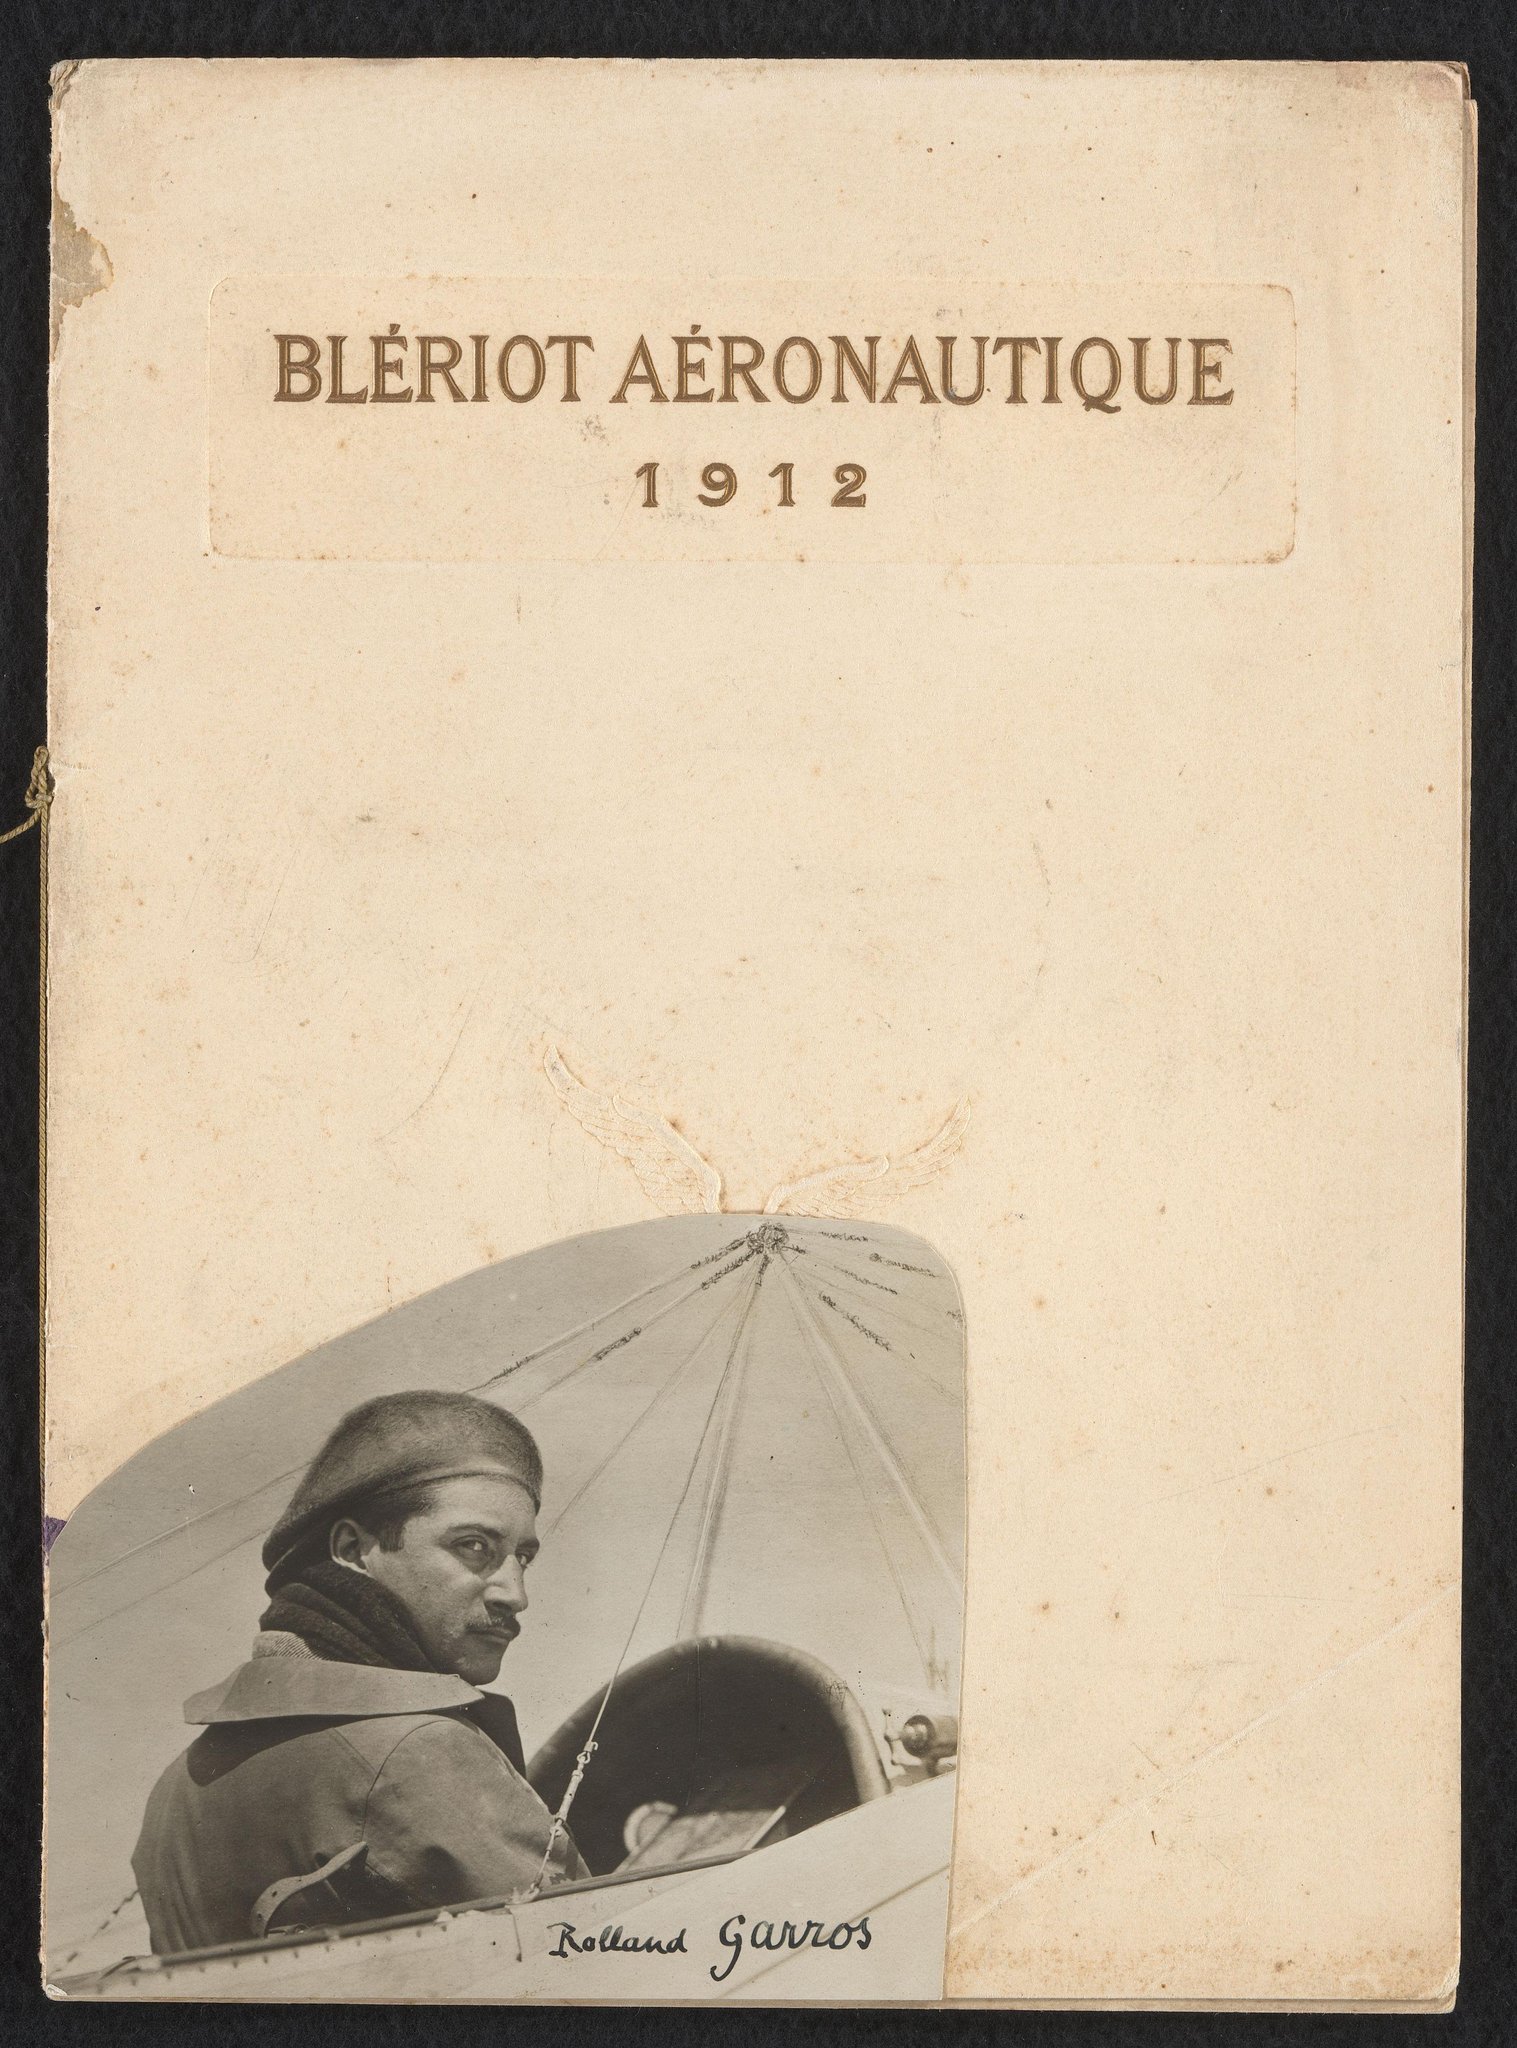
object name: book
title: Blériot Aéronautique 1912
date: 1912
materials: paper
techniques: gelatin silver print, letterpress printing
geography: saint-denis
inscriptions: date: ‘JUNE 2018’